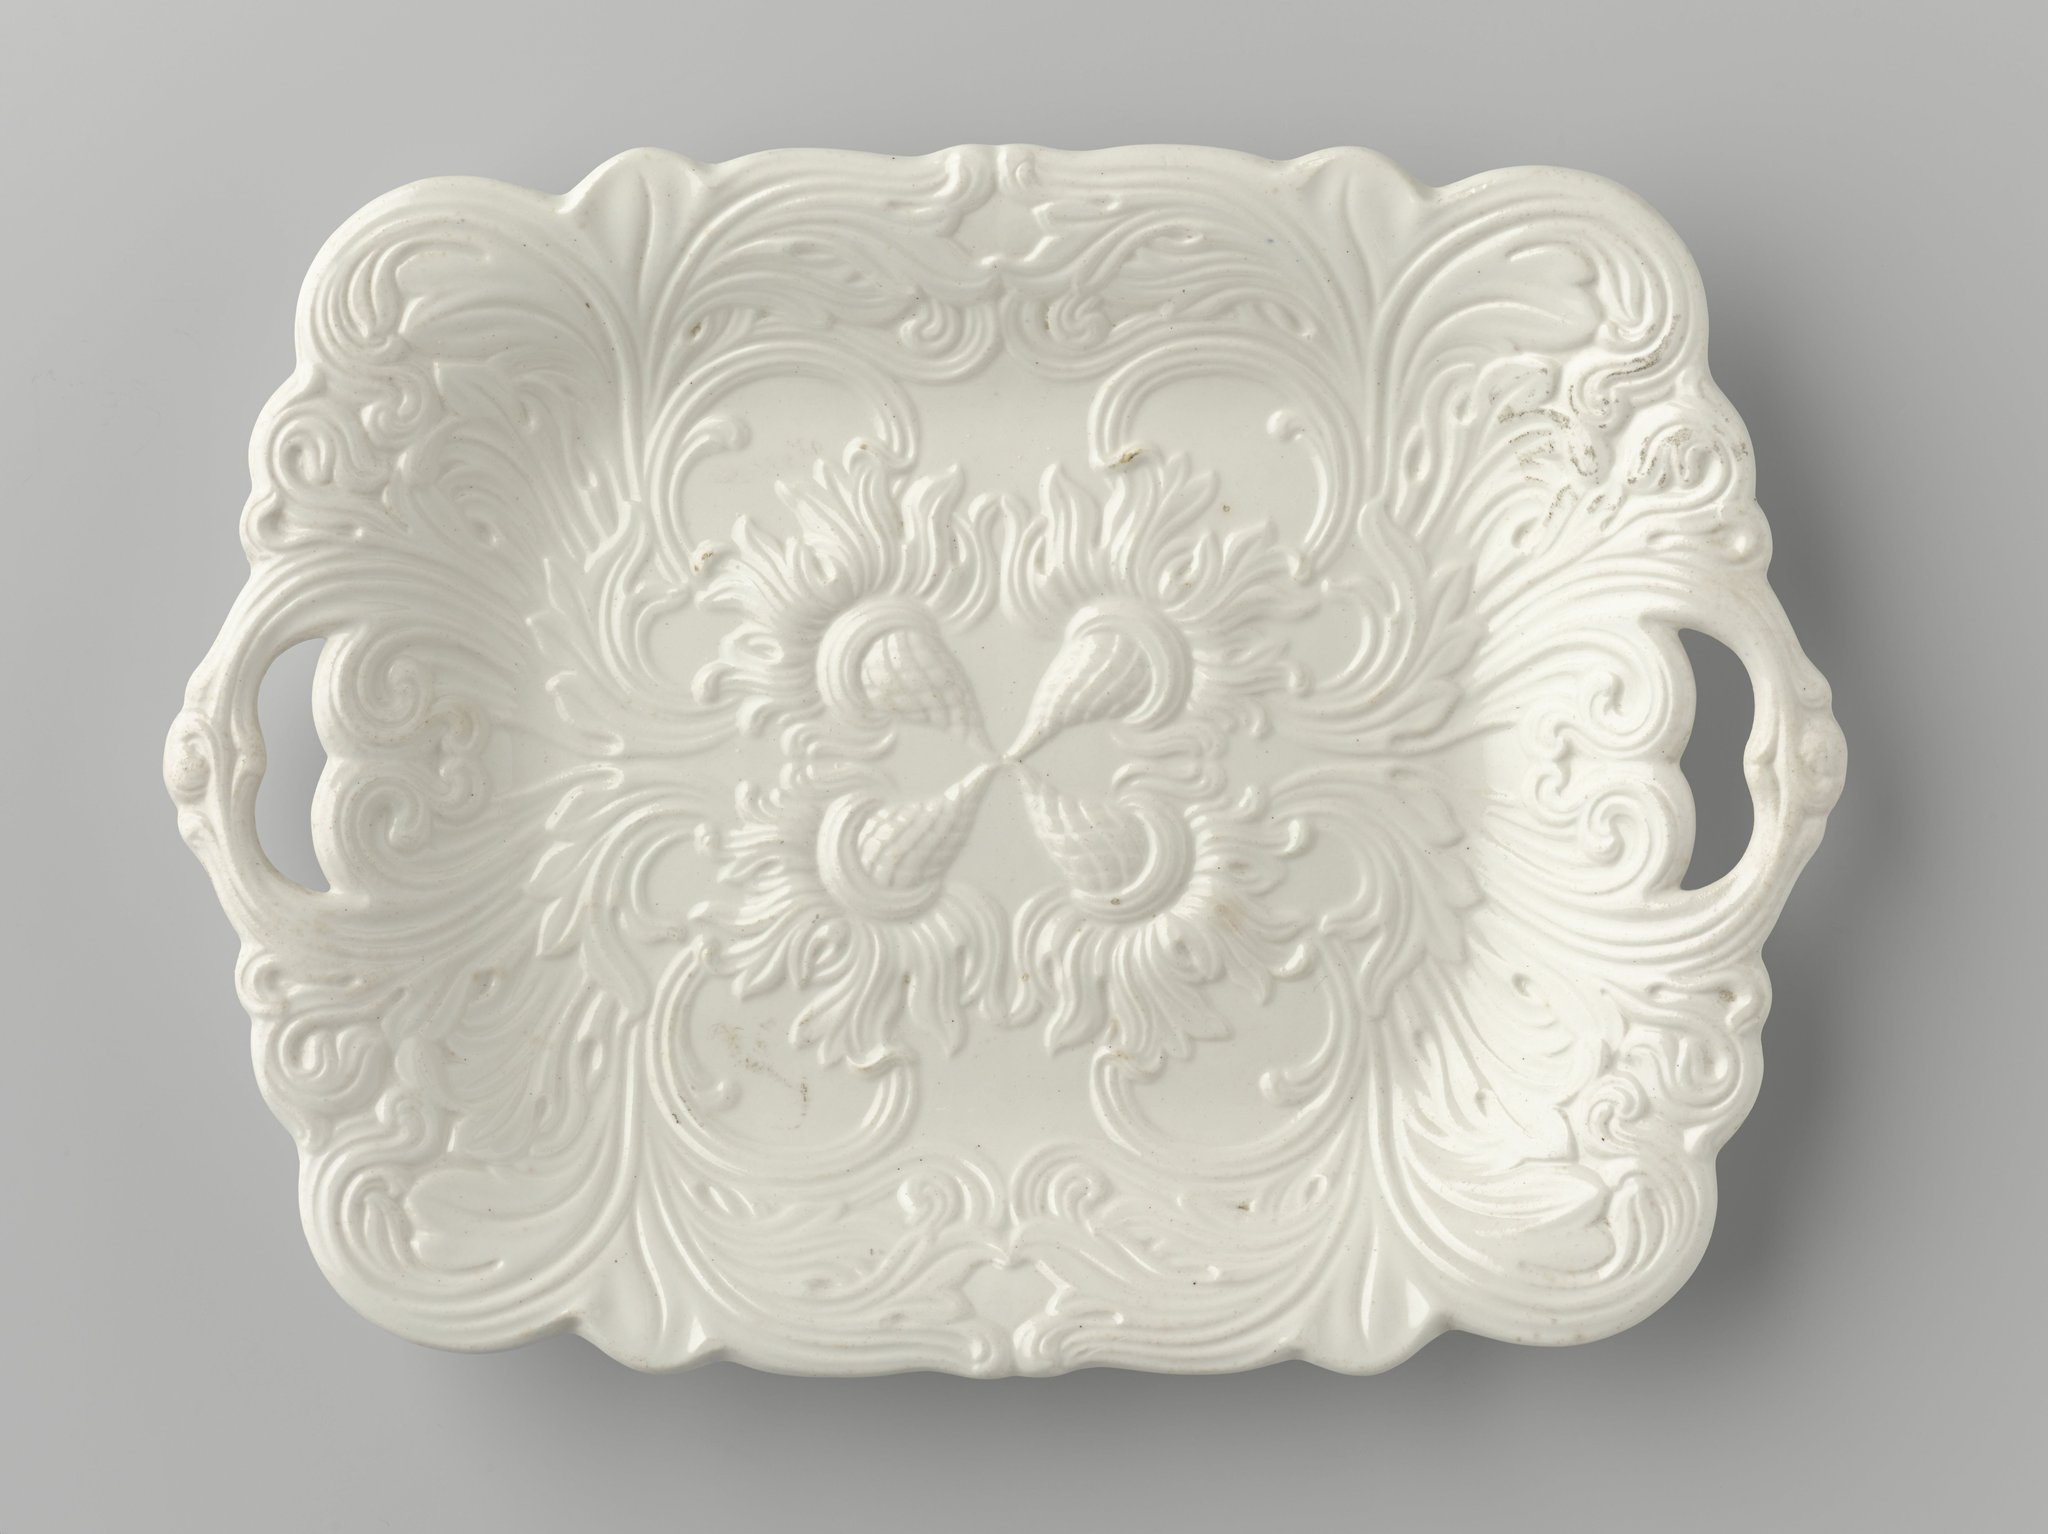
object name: dish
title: Schaal, rechthoekig, met in relief gestileerde bladeren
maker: petrus regout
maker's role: plateelbakker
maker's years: 1801-1879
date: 1801-1879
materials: earthenware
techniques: vitrification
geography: maastricht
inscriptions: check stamp: ‘P. REGOUT // 3 // MAASTRICHT’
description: Schaal van aardewerk, crèmekleurig, rechthoekig, met in reliëf gestileerde bladeren die vanuit vier centraal geplaatste hoorns (?) lijken te komen. De bladeren lopen uit in twee handgrepen.